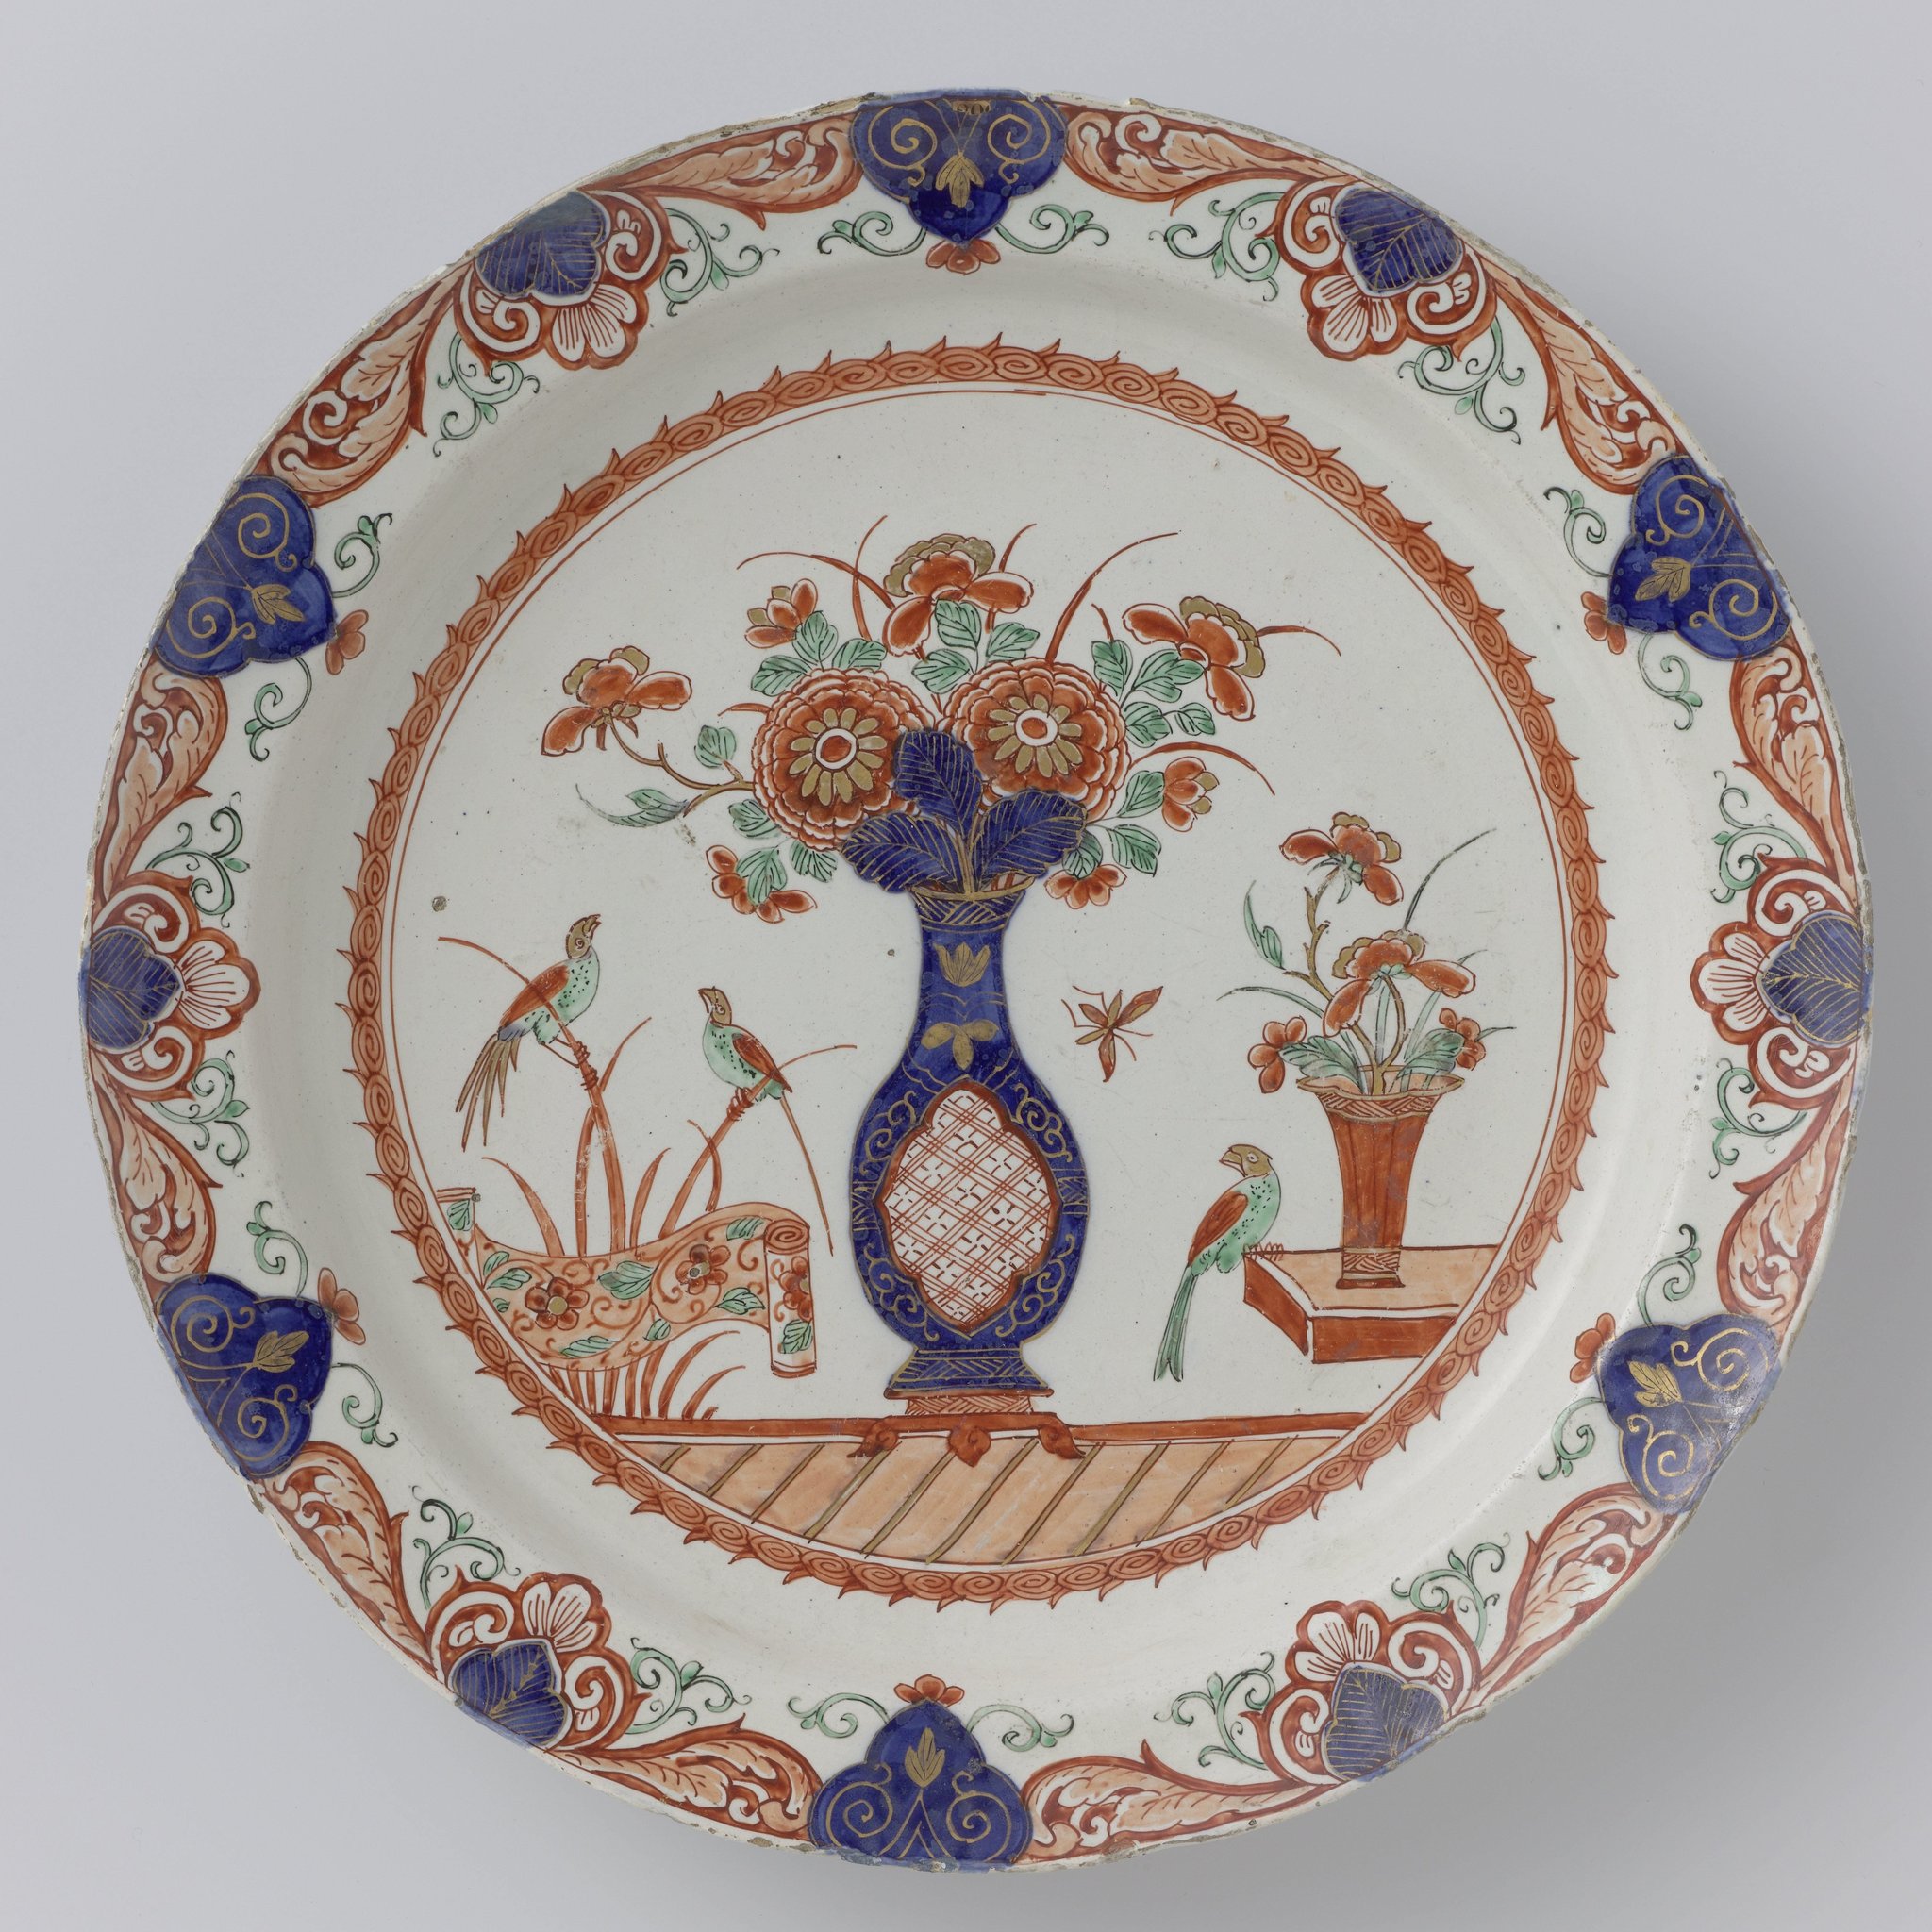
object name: platter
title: Schotel van faïence met bloemenvaas en vogels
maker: pieter adriaensz. kocx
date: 1705-1725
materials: earthenware, glaze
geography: delft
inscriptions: inscription: ‘A'dam RM 6’, mark: ‘APK (ineen)’, collector's mark: ‘collection loudon’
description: Schotel van faïence. Beschilderd met een bloemenvaas en vogels.